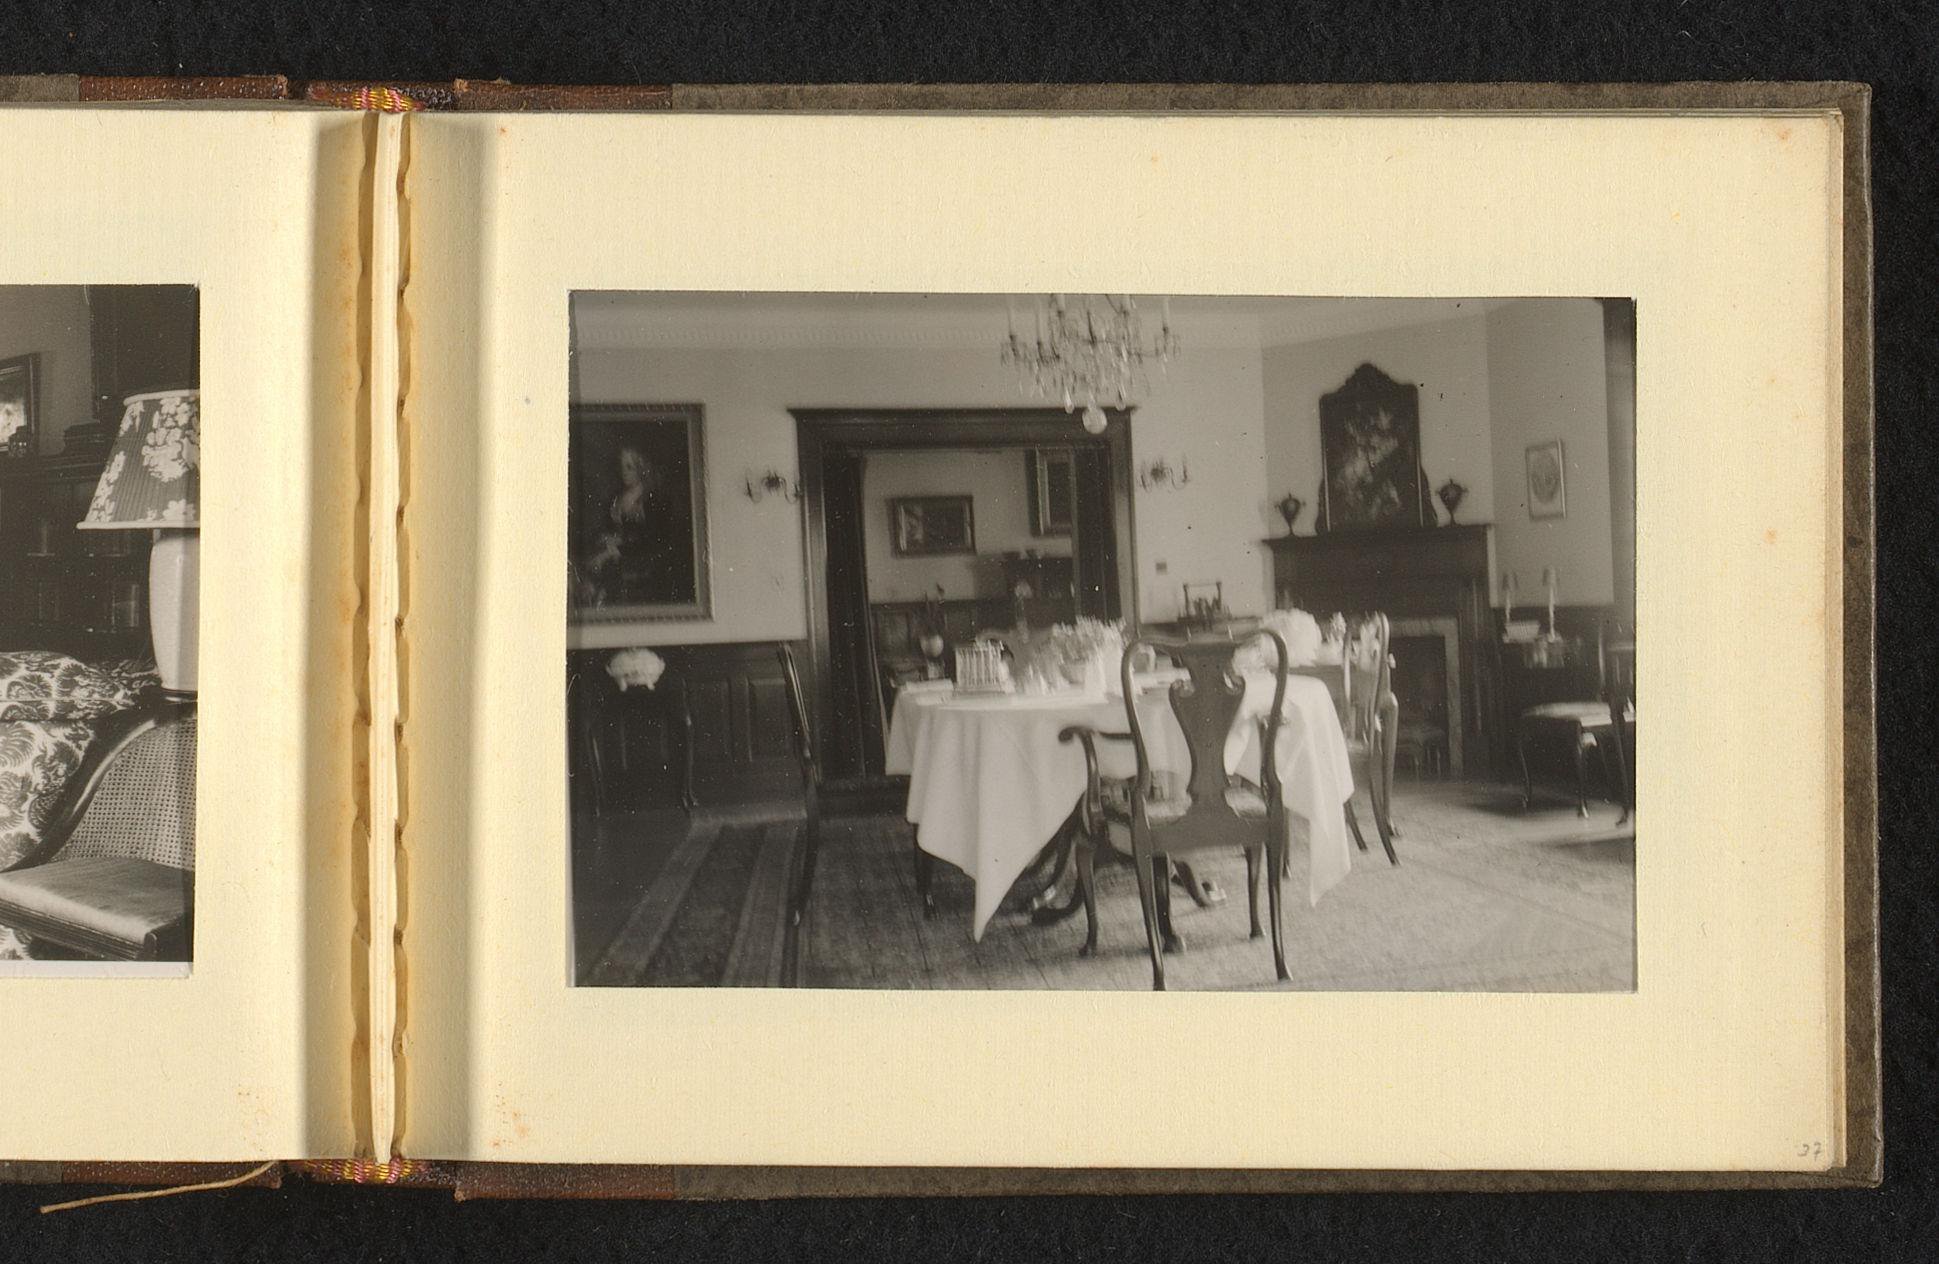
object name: album leaf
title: Interieur van een eetkamer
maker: norbert van den berg (1901-1972)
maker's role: amateurfotograaf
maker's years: 1901-1972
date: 1935-1950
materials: paper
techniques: gelatin silver print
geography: netherlands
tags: interior of the house, dining-room